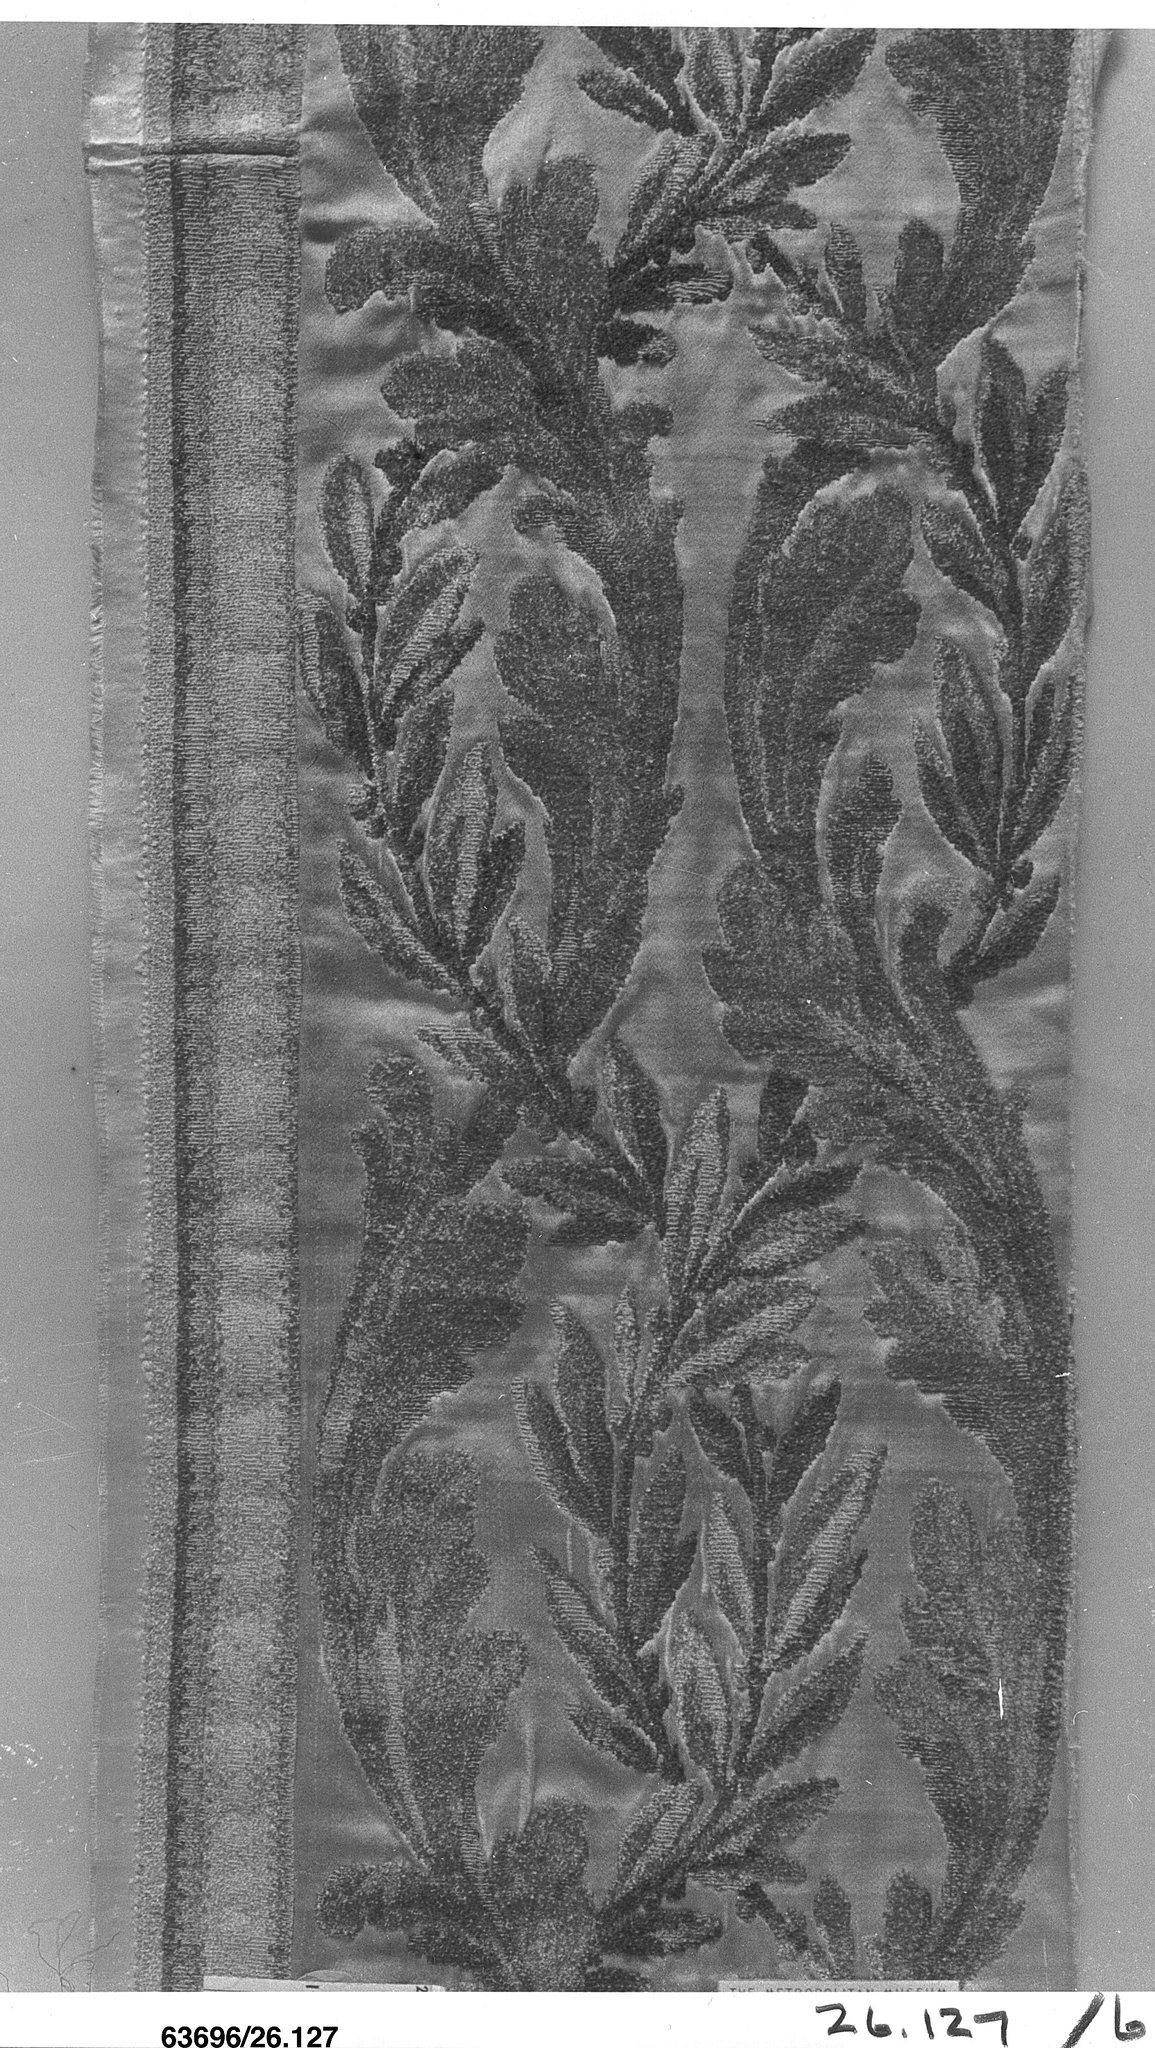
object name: border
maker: philippe de lasalle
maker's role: designer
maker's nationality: french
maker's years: 1723-1804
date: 1767-1800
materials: silk